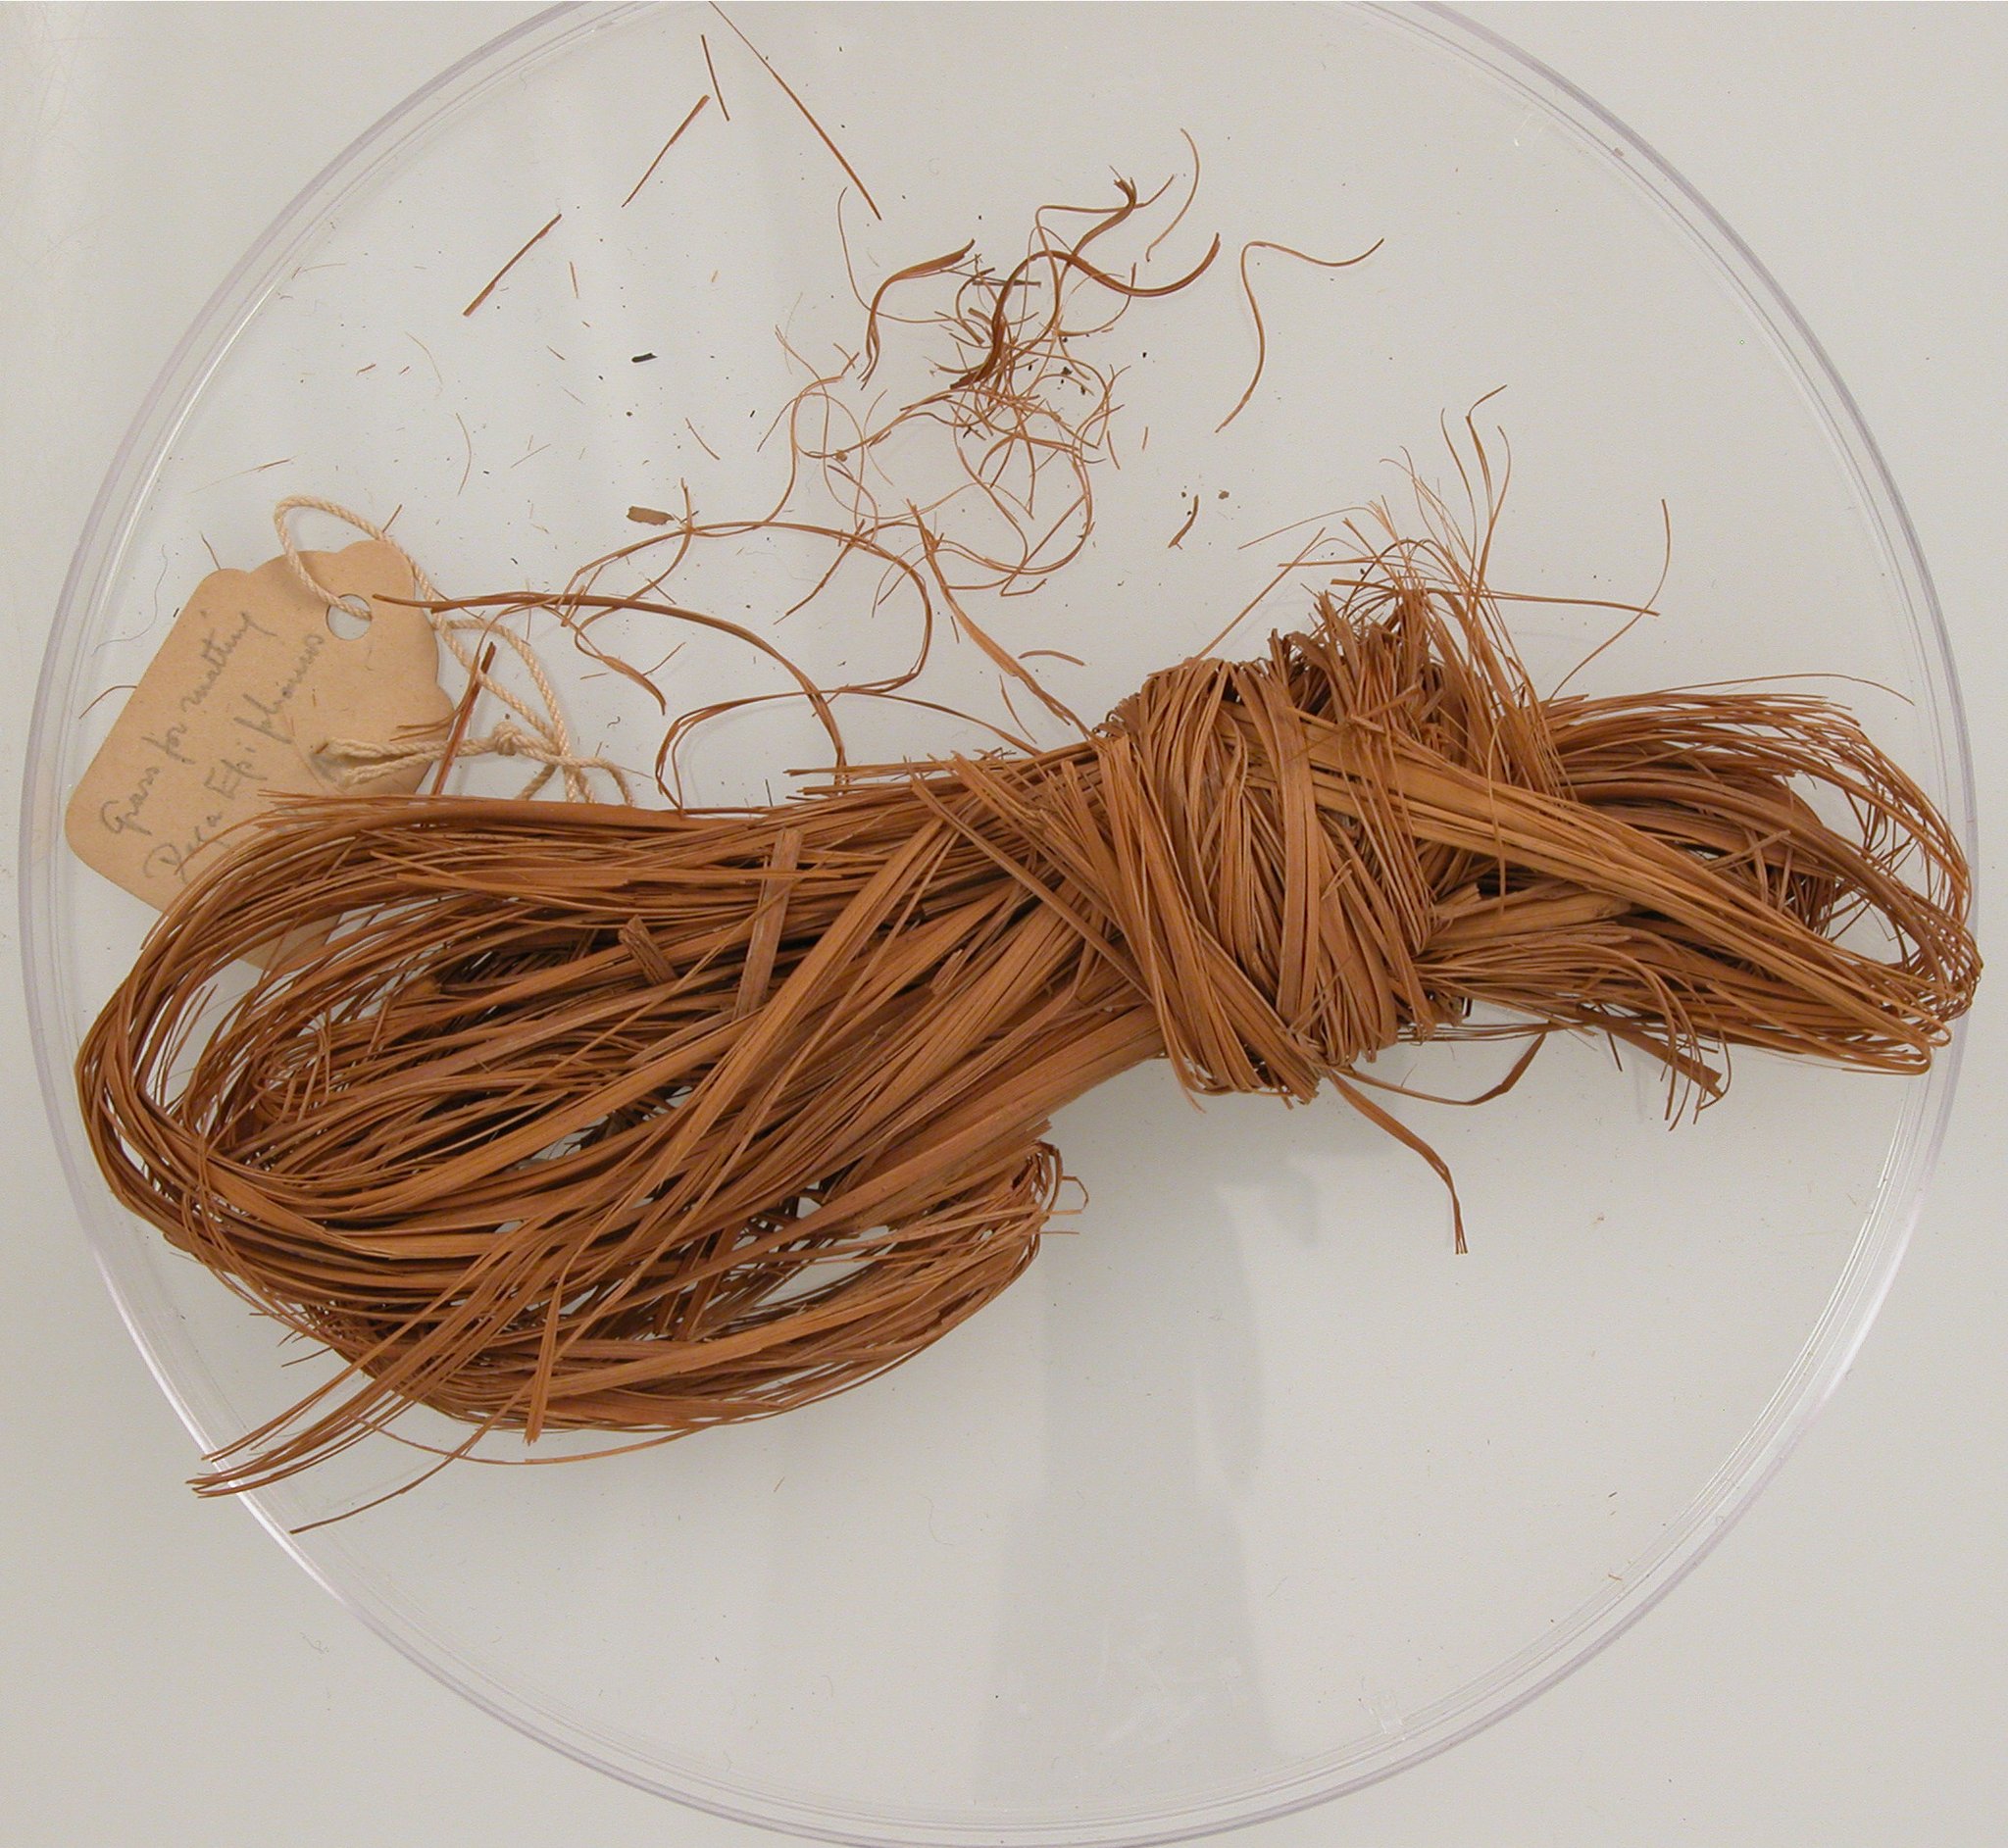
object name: grass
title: Bundle of Grass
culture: coptic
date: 580-640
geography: egypt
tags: plants